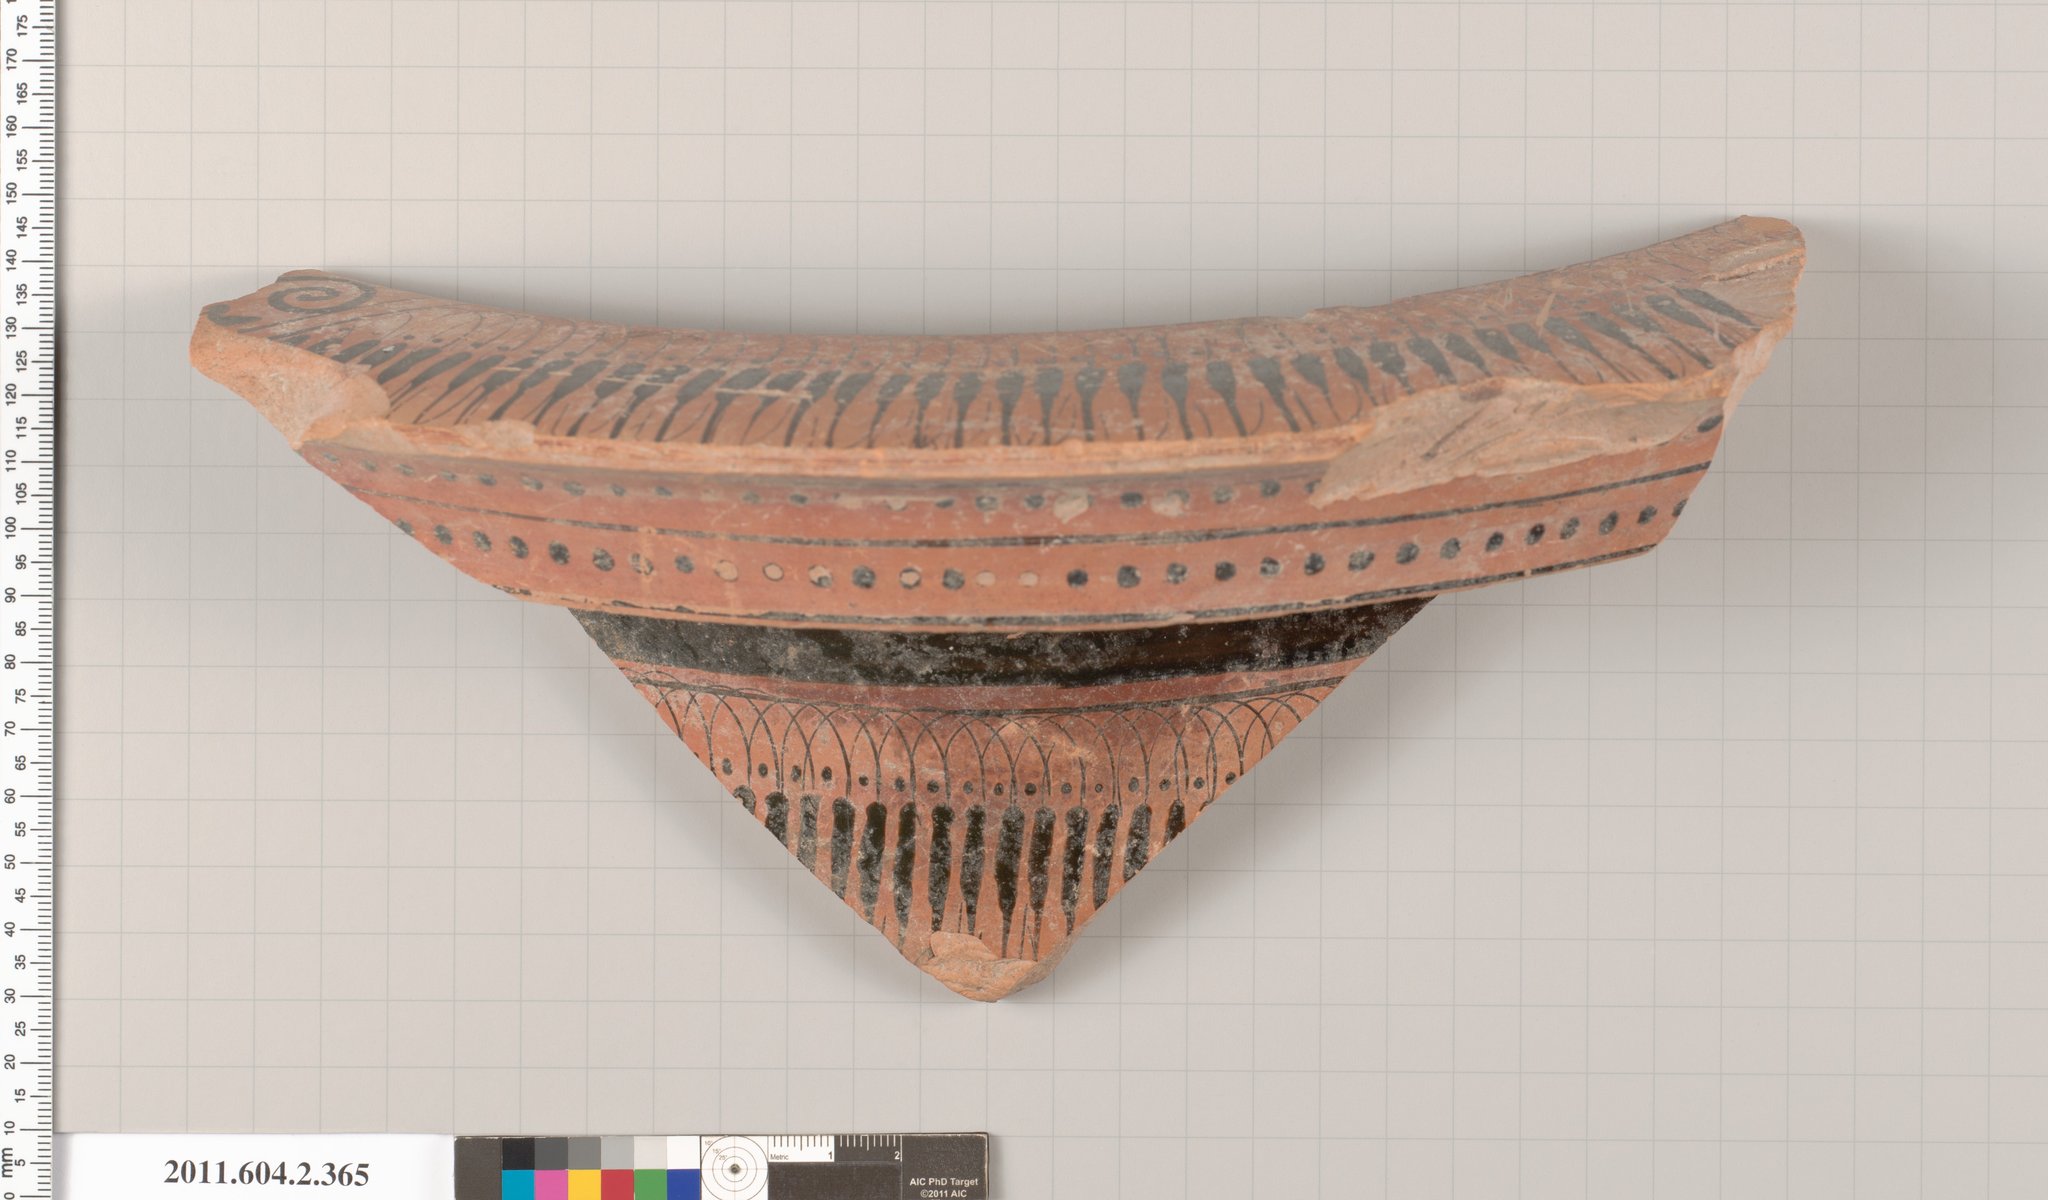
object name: column krater fragment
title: Terracotta fragment of a column-krater (bowl for mixing wine and water)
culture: greek, attic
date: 450-430 BCE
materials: terracotta